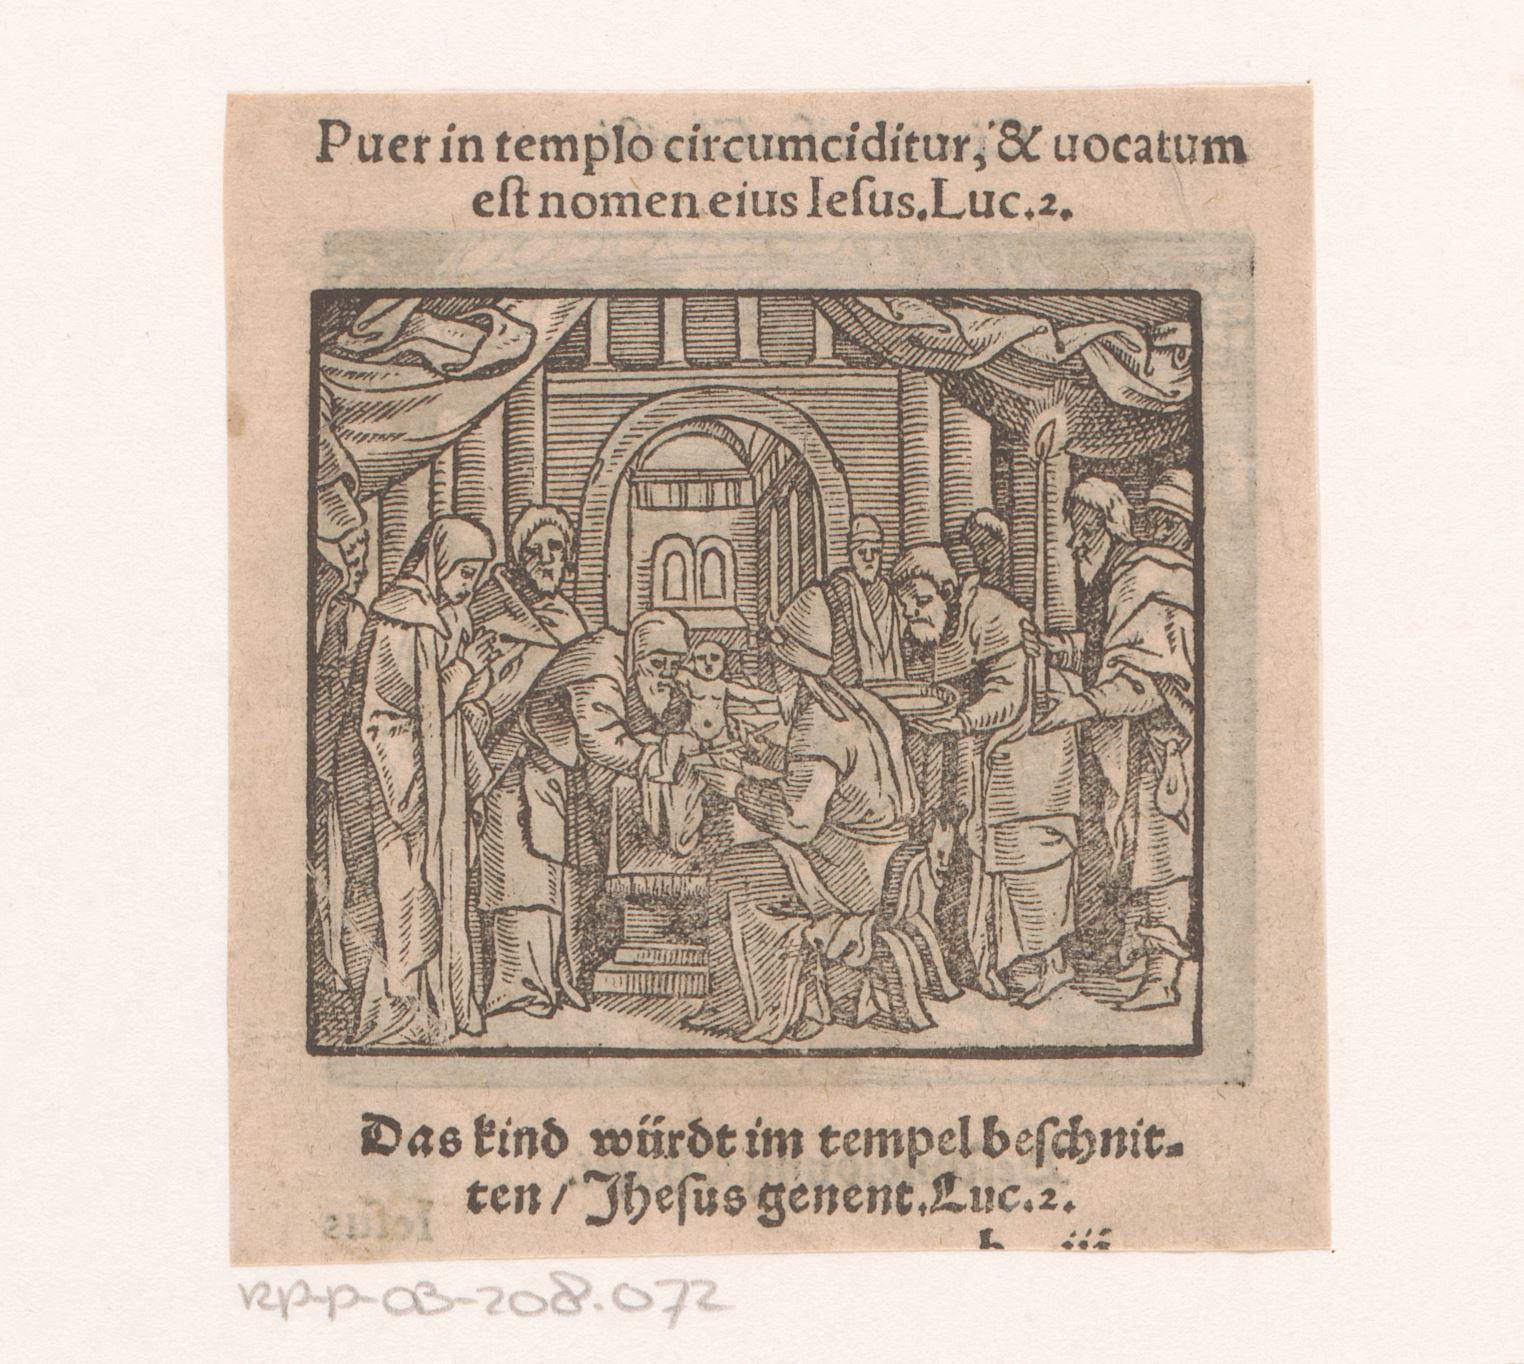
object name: print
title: Besnijdenis van Christus in de tempel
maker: Anonymous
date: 1600-1699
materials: paper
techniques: letterpress printing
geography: netherlands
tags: circumcision of the christ-child by the priest in the temple (luke 2:21)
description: De priester voert de ingreep bij Christus uit. Links staan Maria en Jozef.